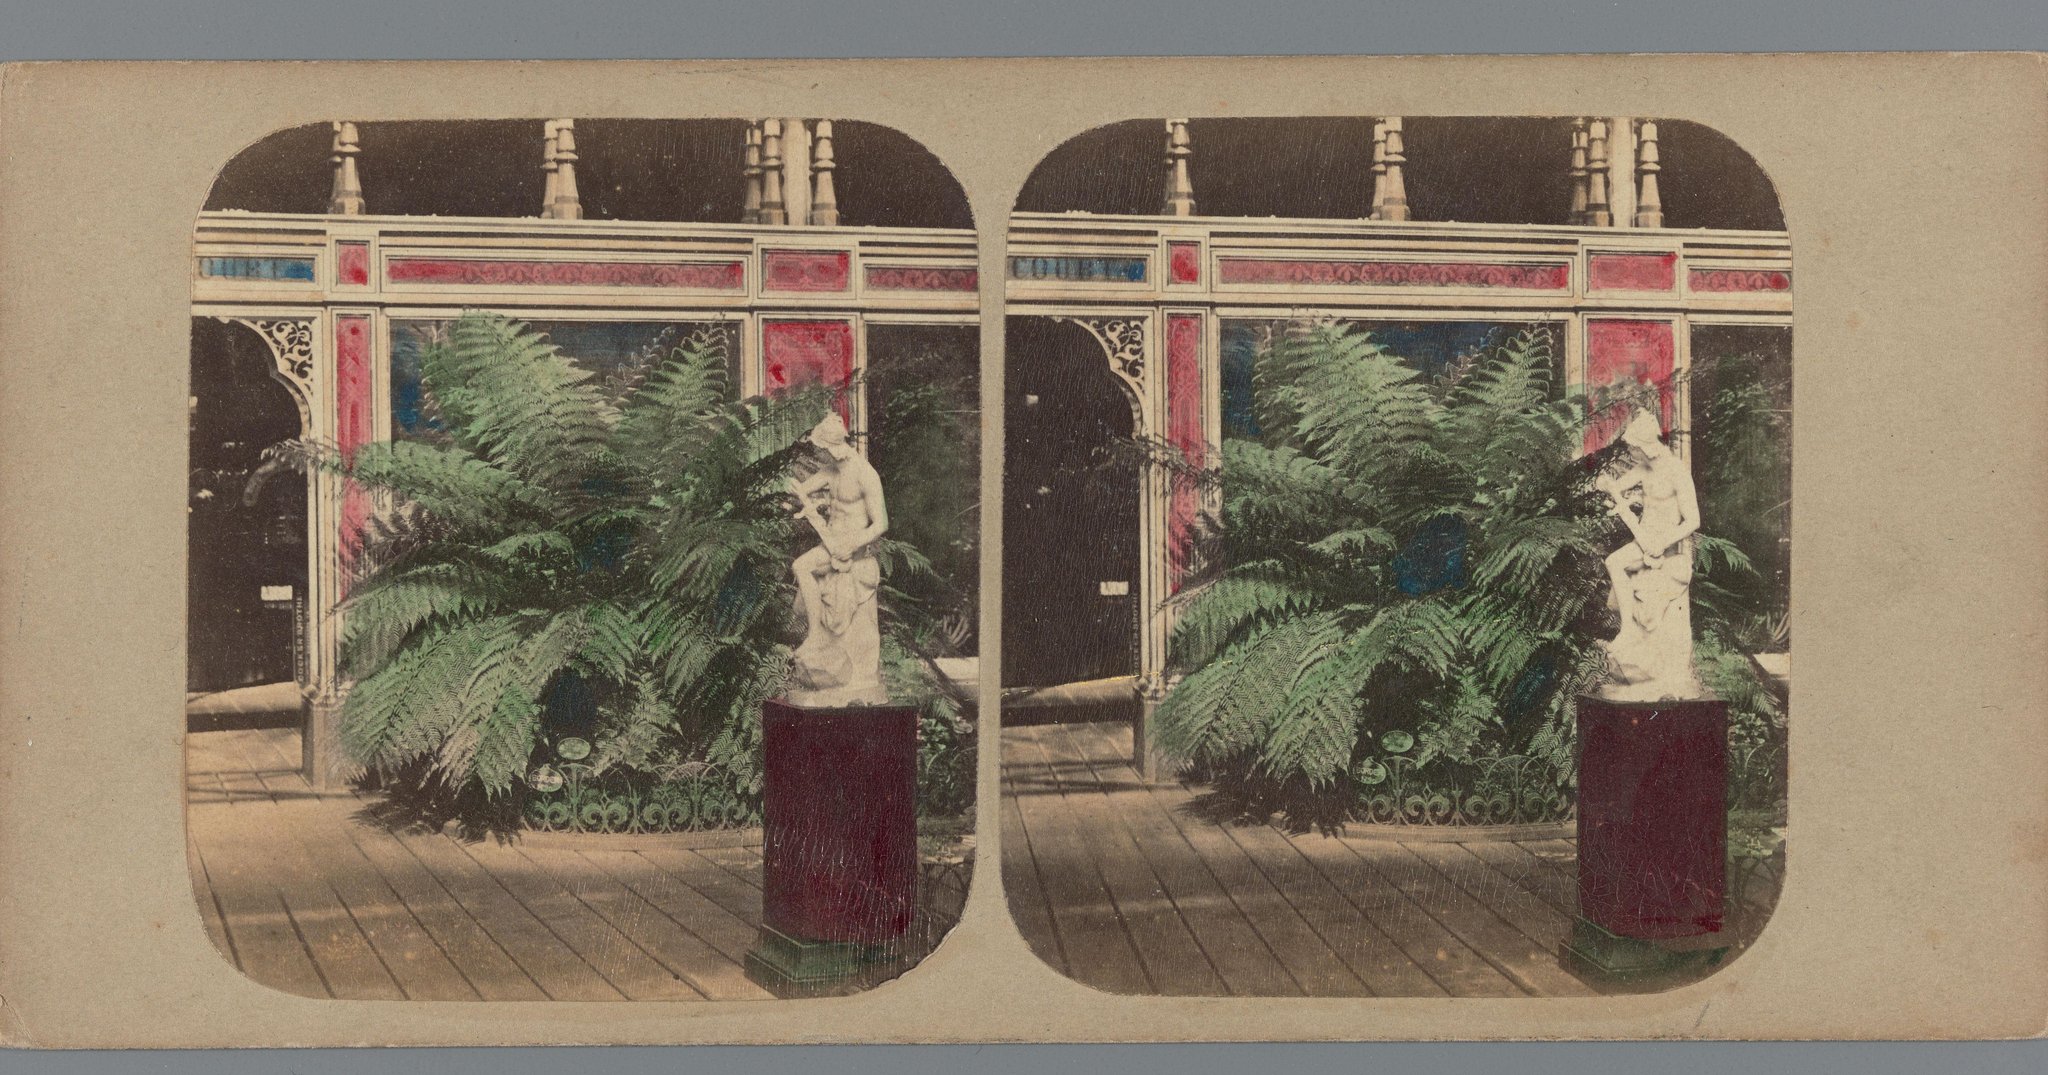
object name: stereograph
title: Standbeeld bij het Sheffield Court van Crystal Palace in Sydenham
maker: Anonymous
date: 1870-1890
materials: cardboard, paper, photographic support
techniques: albumen print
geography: crystal palace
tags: piece of sculpture, reproduction of a piece of sculpture, interior ~ representation of a building